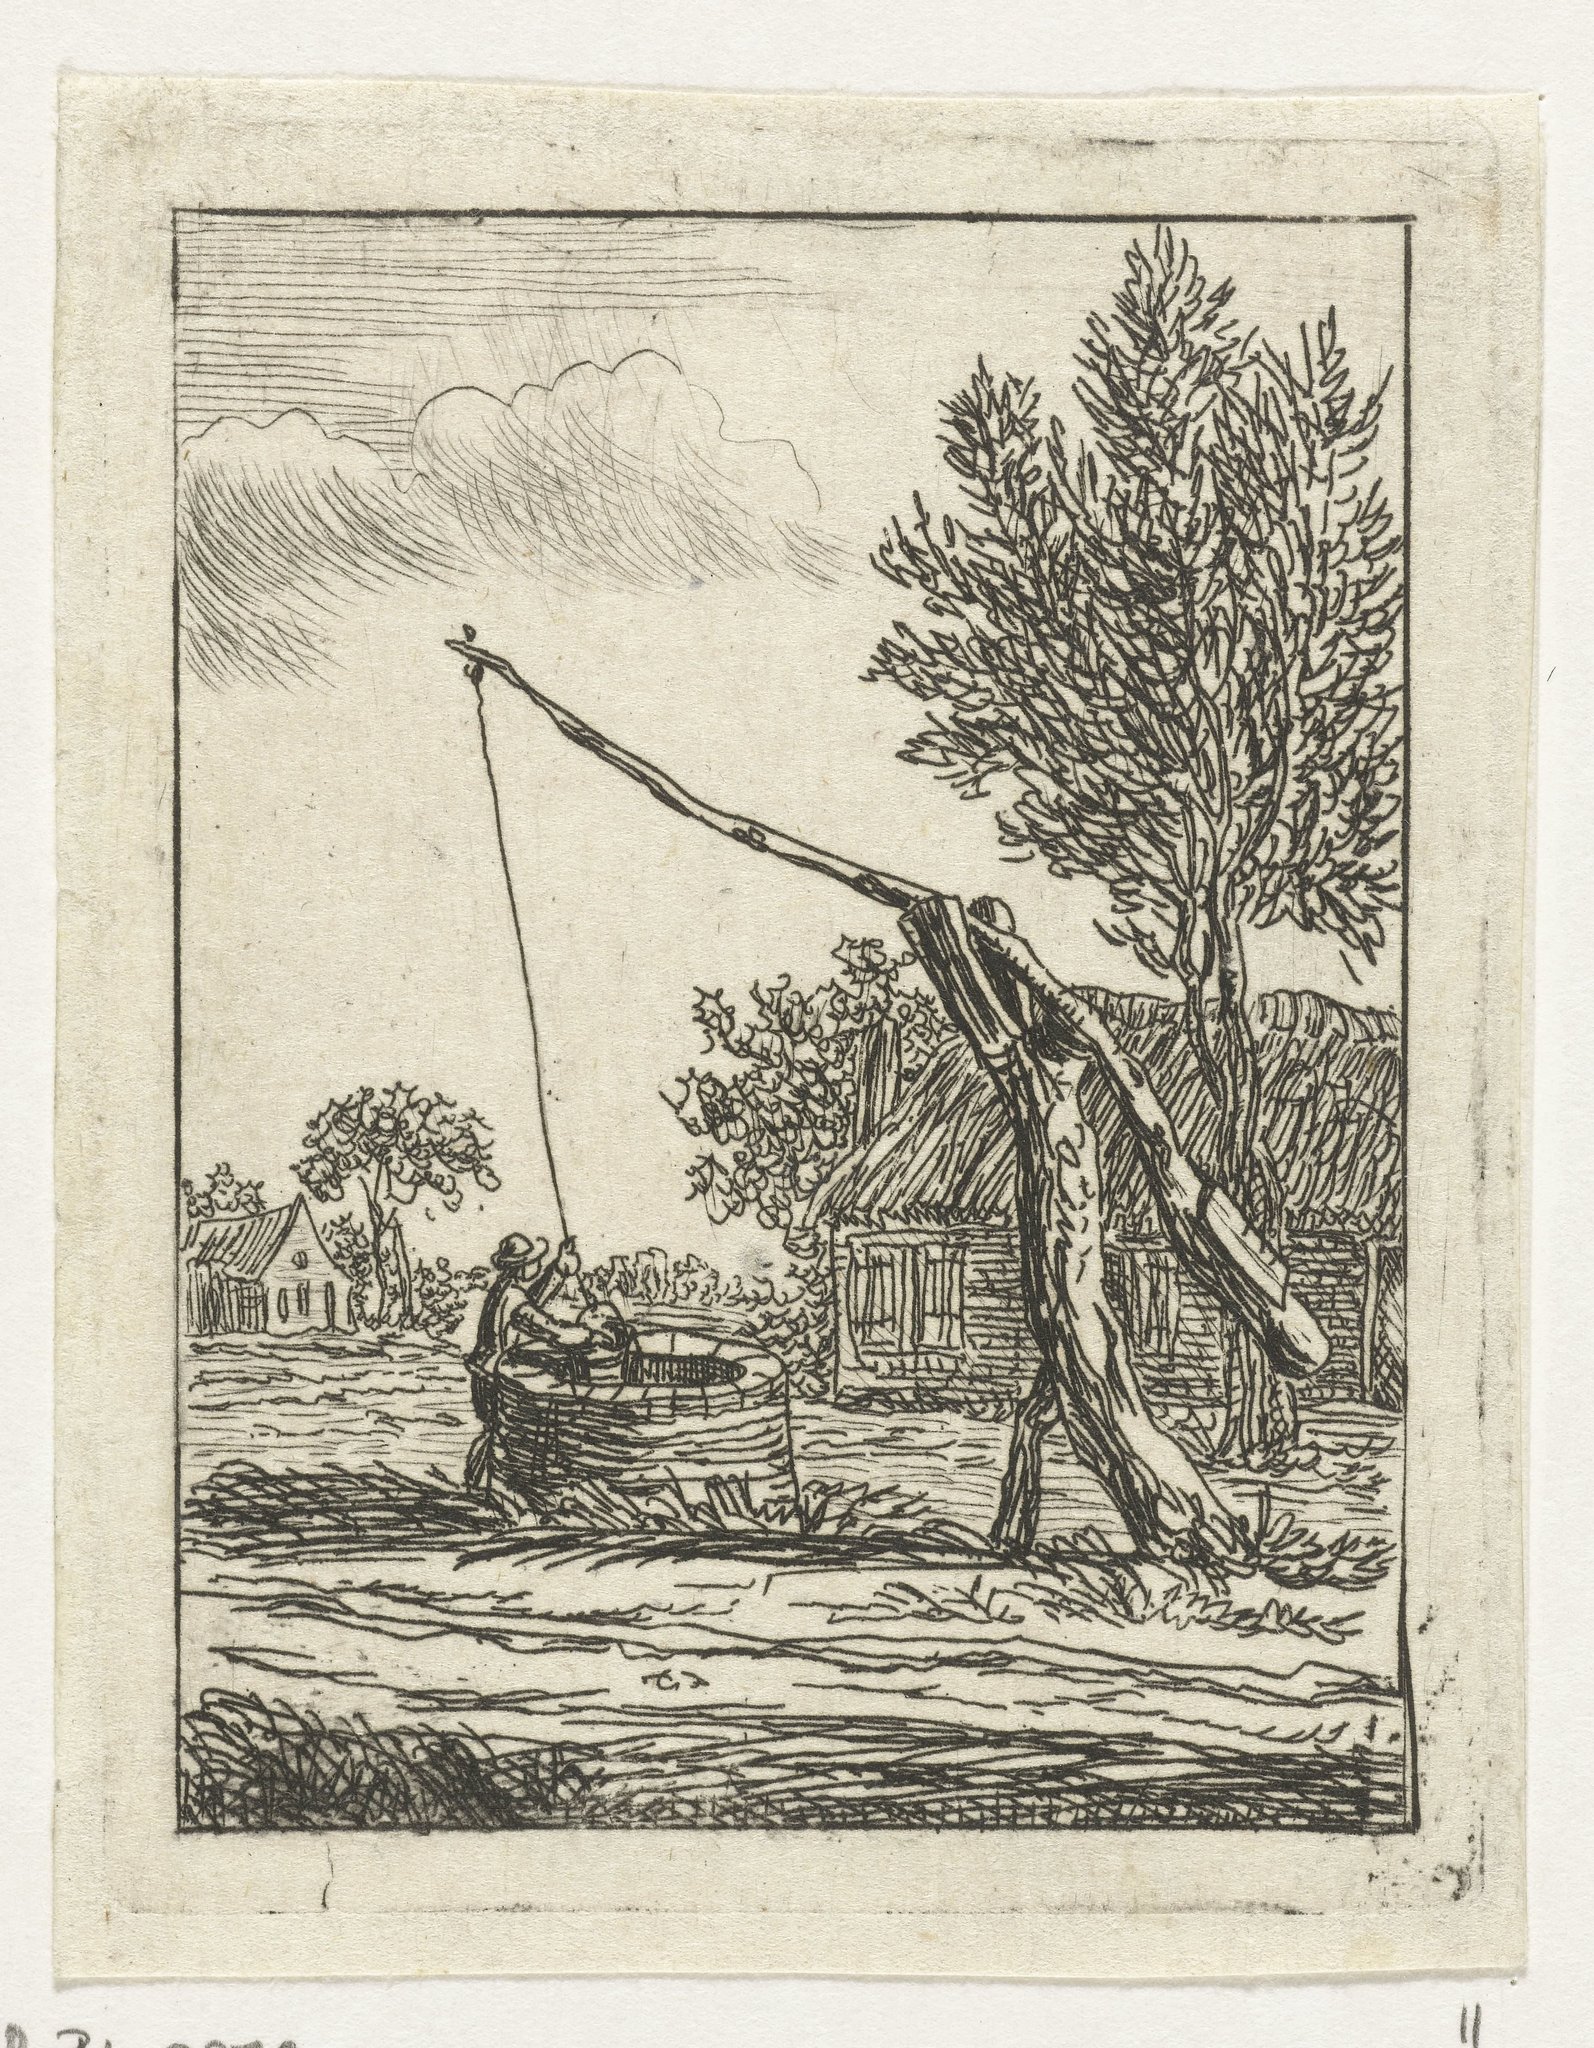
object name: print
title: Put met haalboom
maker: anthonie van den bos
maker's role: draughtsman, print maker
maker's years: 1763-1838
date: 1778-1838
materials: paper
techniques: etching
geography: netherlands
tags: utilitarian, public pump or water fountain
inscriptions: collector's mark: Lugt 2228